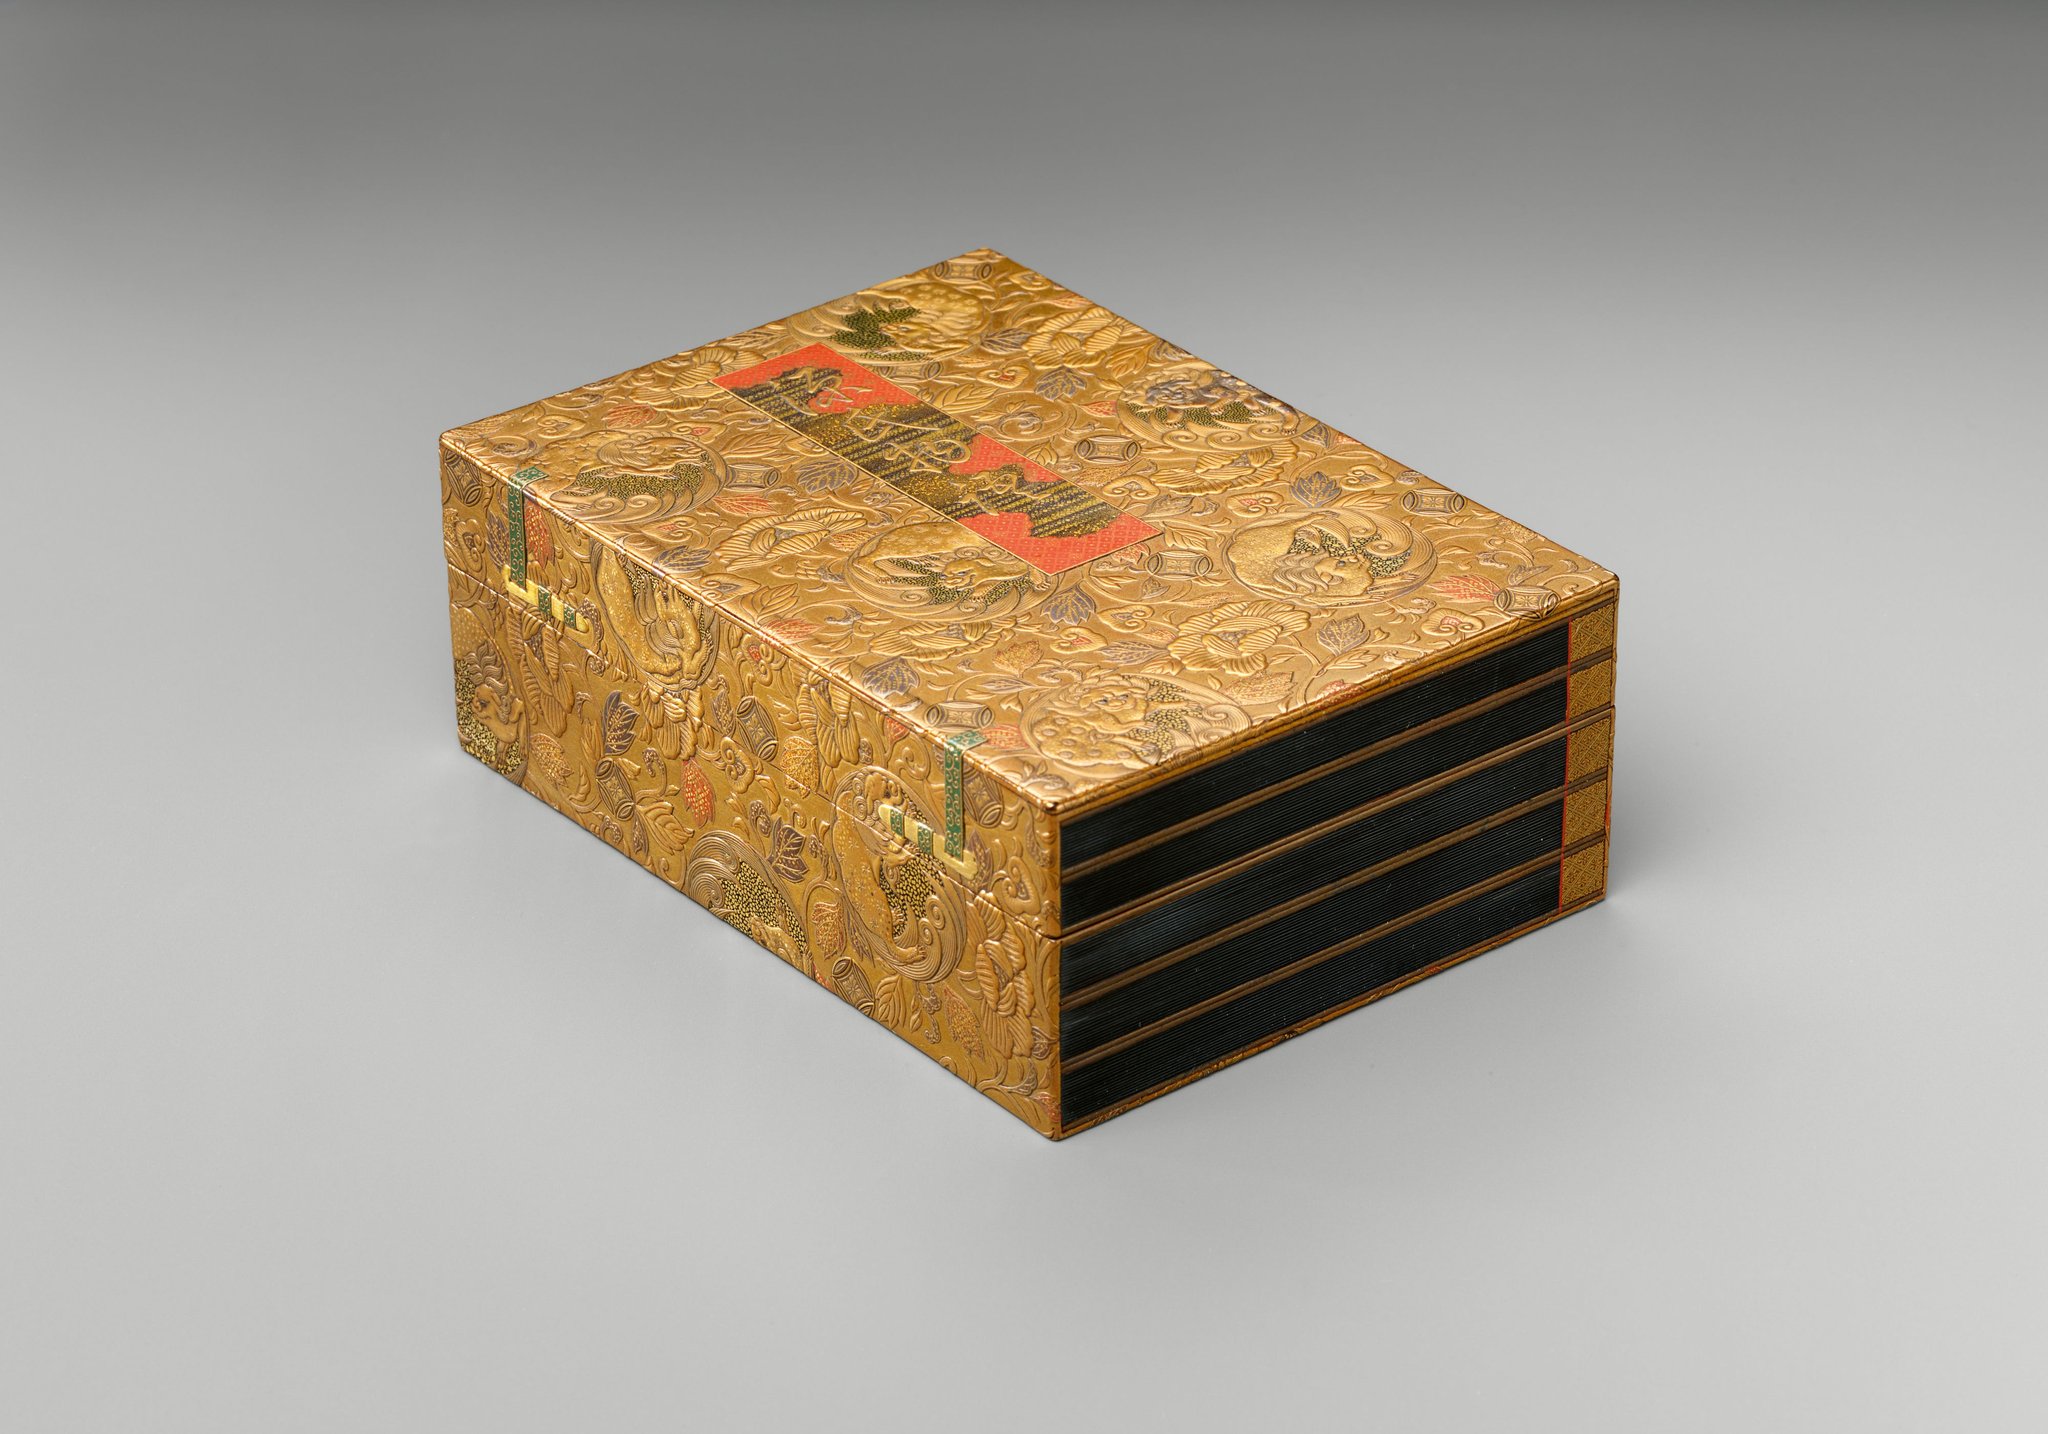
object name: box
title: Incense Box (kōbako) in the Shape of Five Volumes of The Tale of Genji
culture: japanese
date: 1867-1900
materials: foil, gold, lacquer, silver, wood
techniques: hiramakie, lacquer, maki-e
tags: flowers